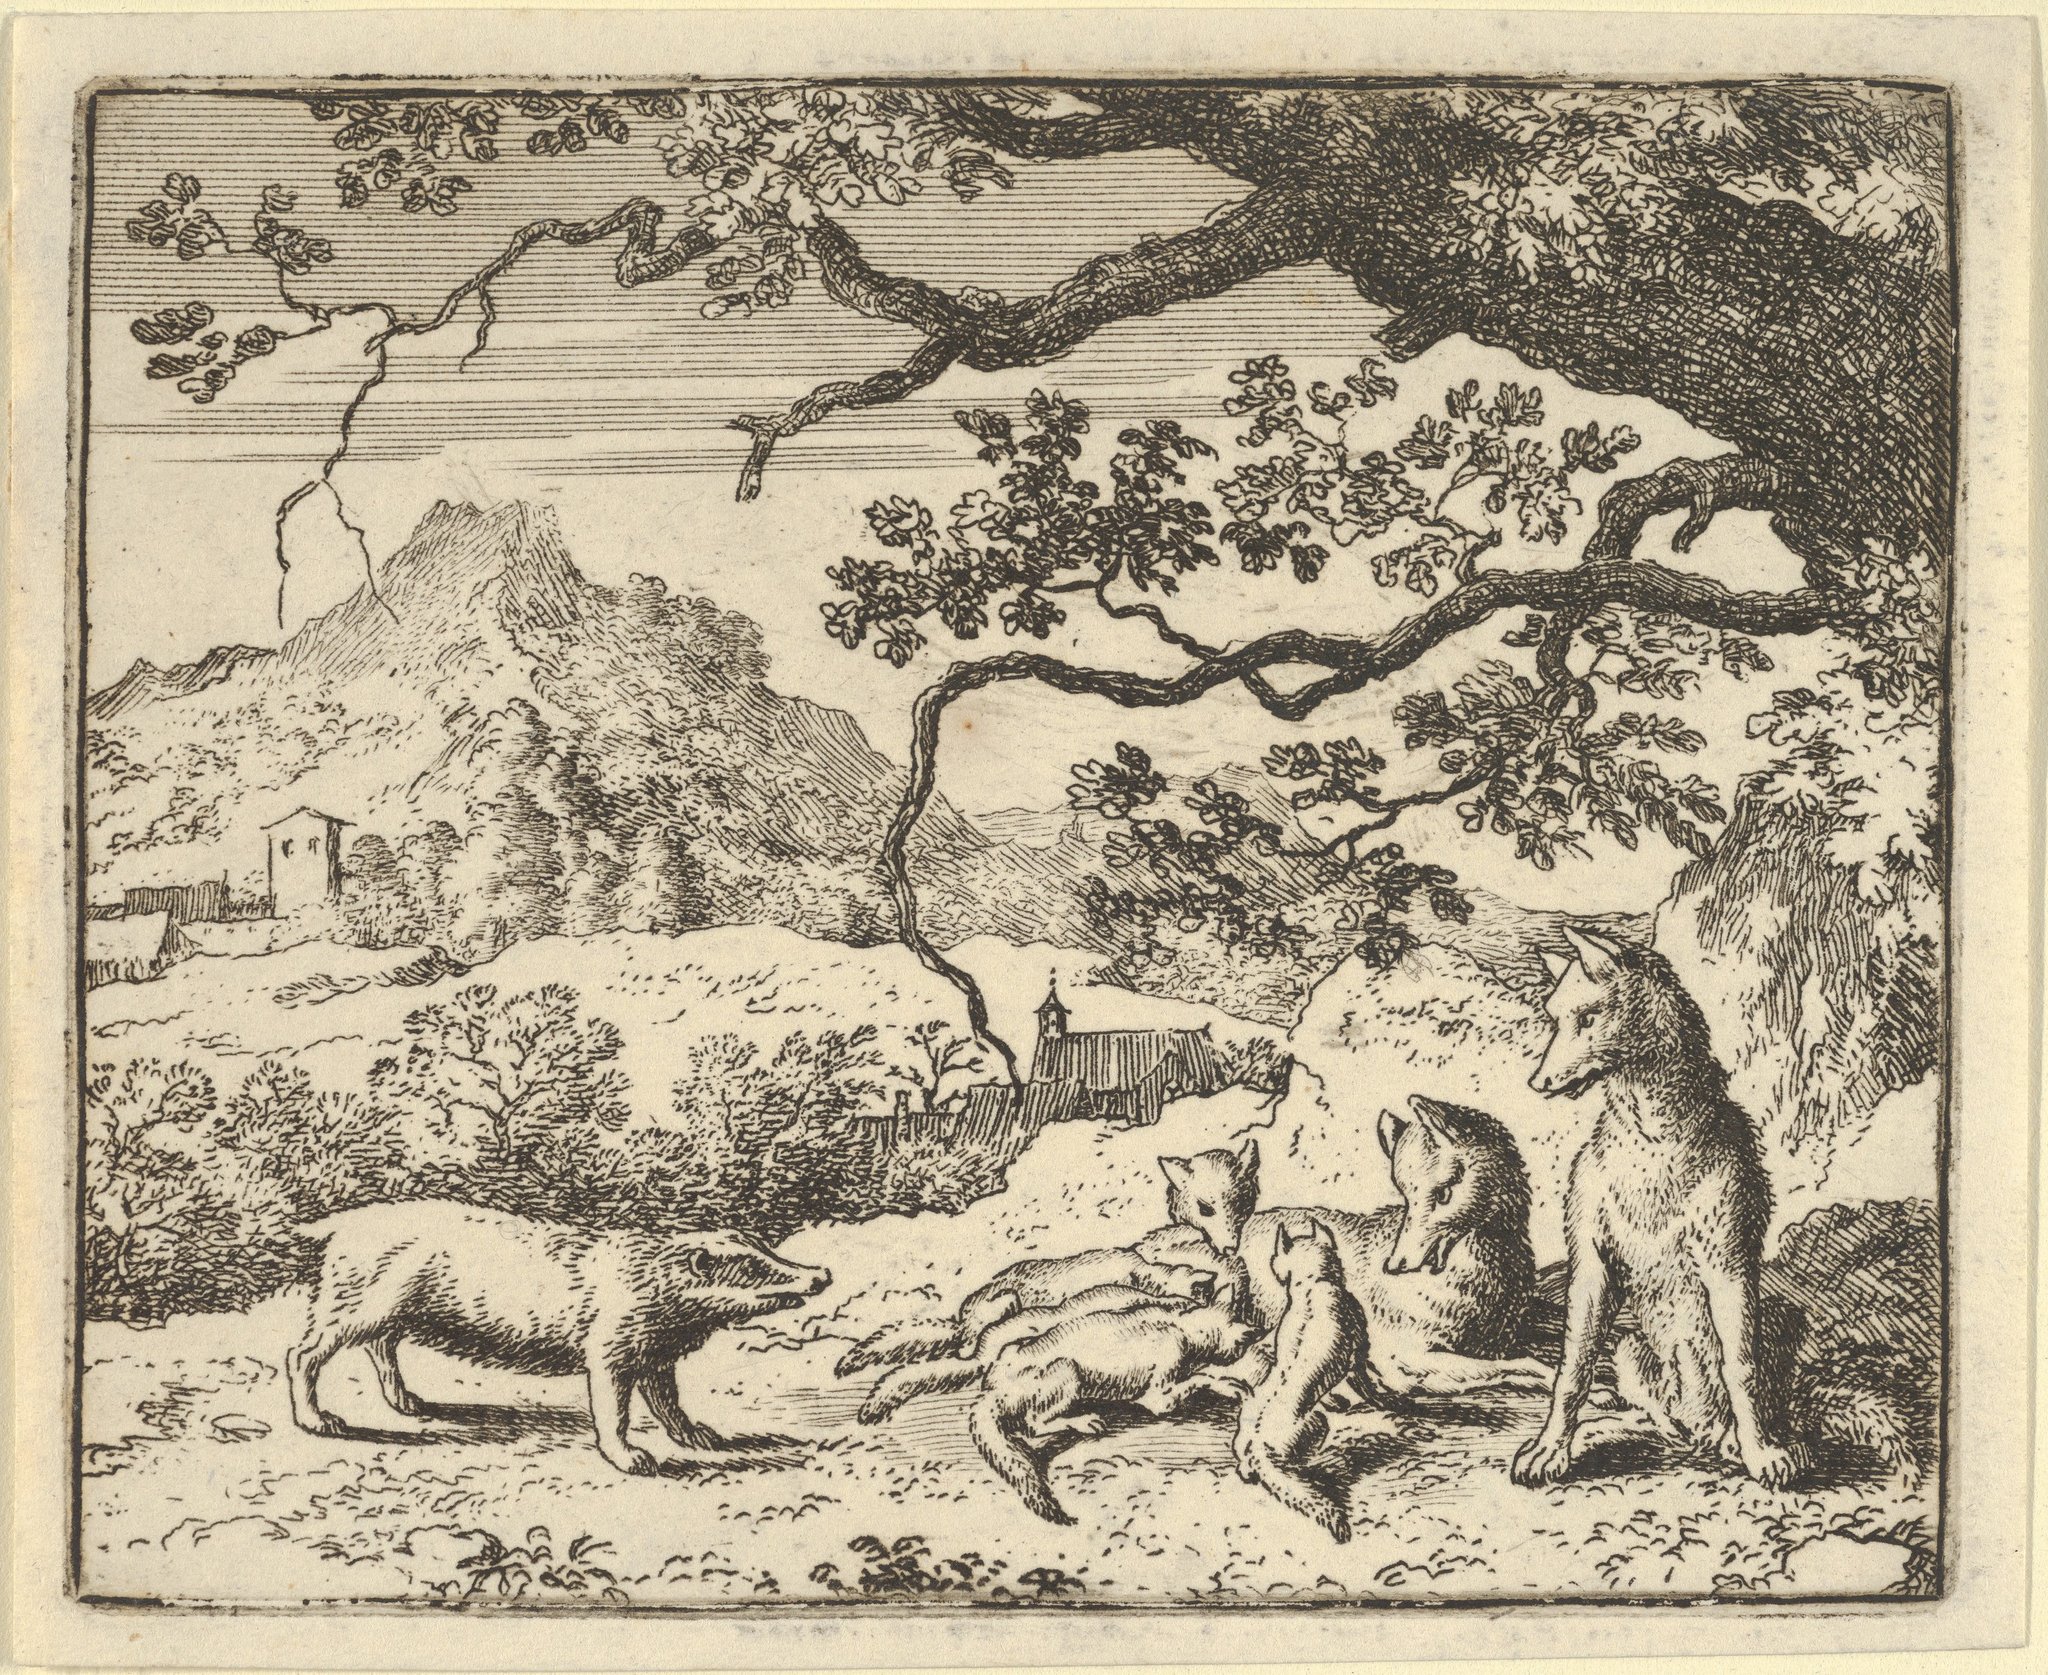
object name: print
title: Renard Receives a New Citation from the Badger from Hendrick van Alcmar's Renard The Fox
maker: allart van everdingen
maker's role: artist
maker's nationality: dutch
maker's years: 1621-1675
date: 1650-1675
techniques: engraving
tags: foxes,landscapes